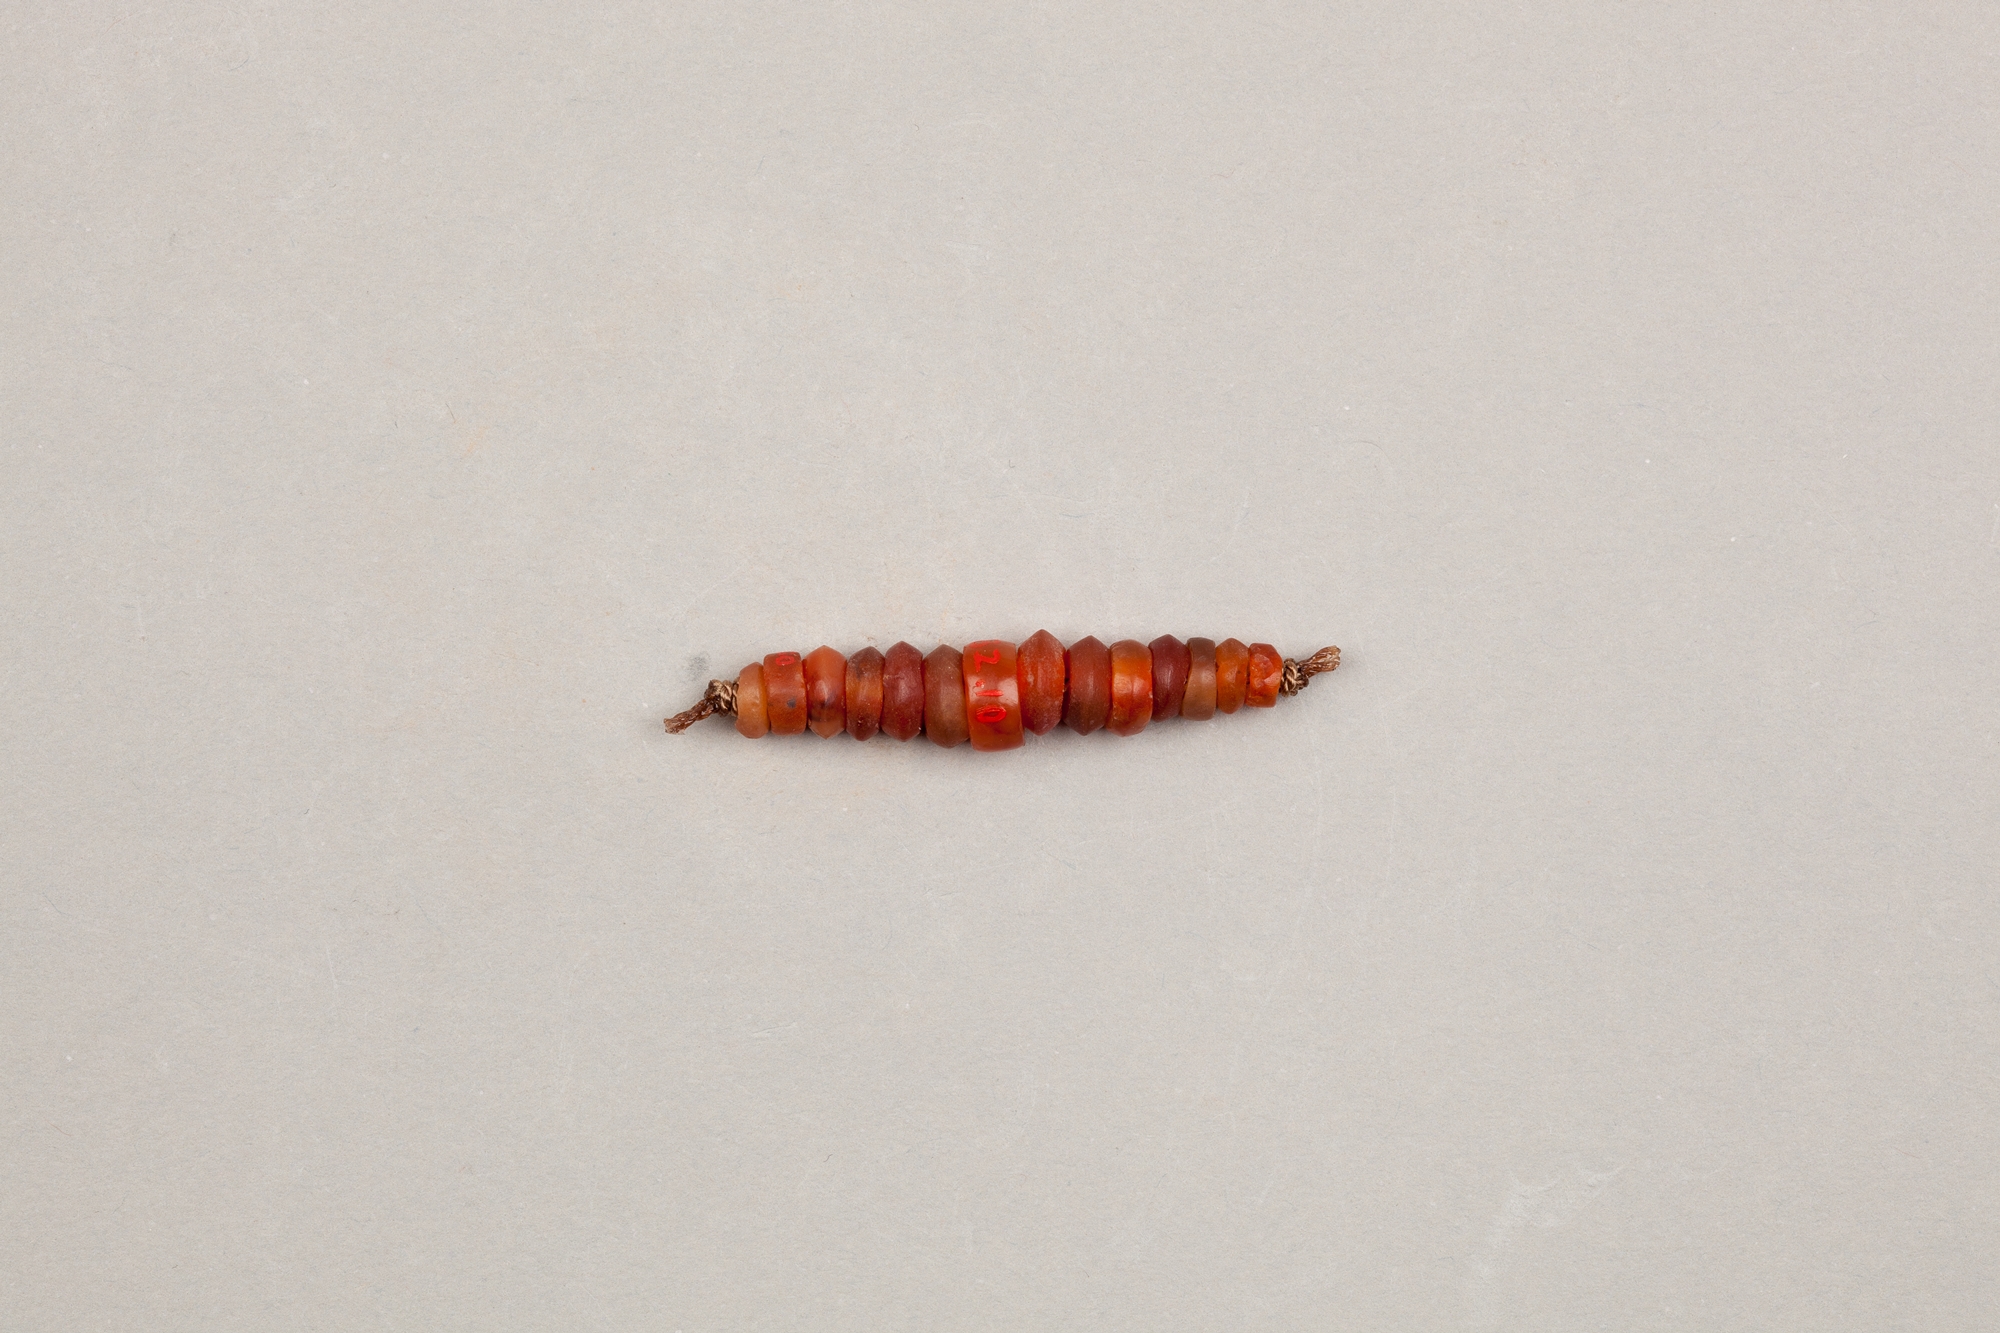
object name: bead, string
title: String of beads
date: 3850-2960 BCE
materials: gemstone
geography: egypt